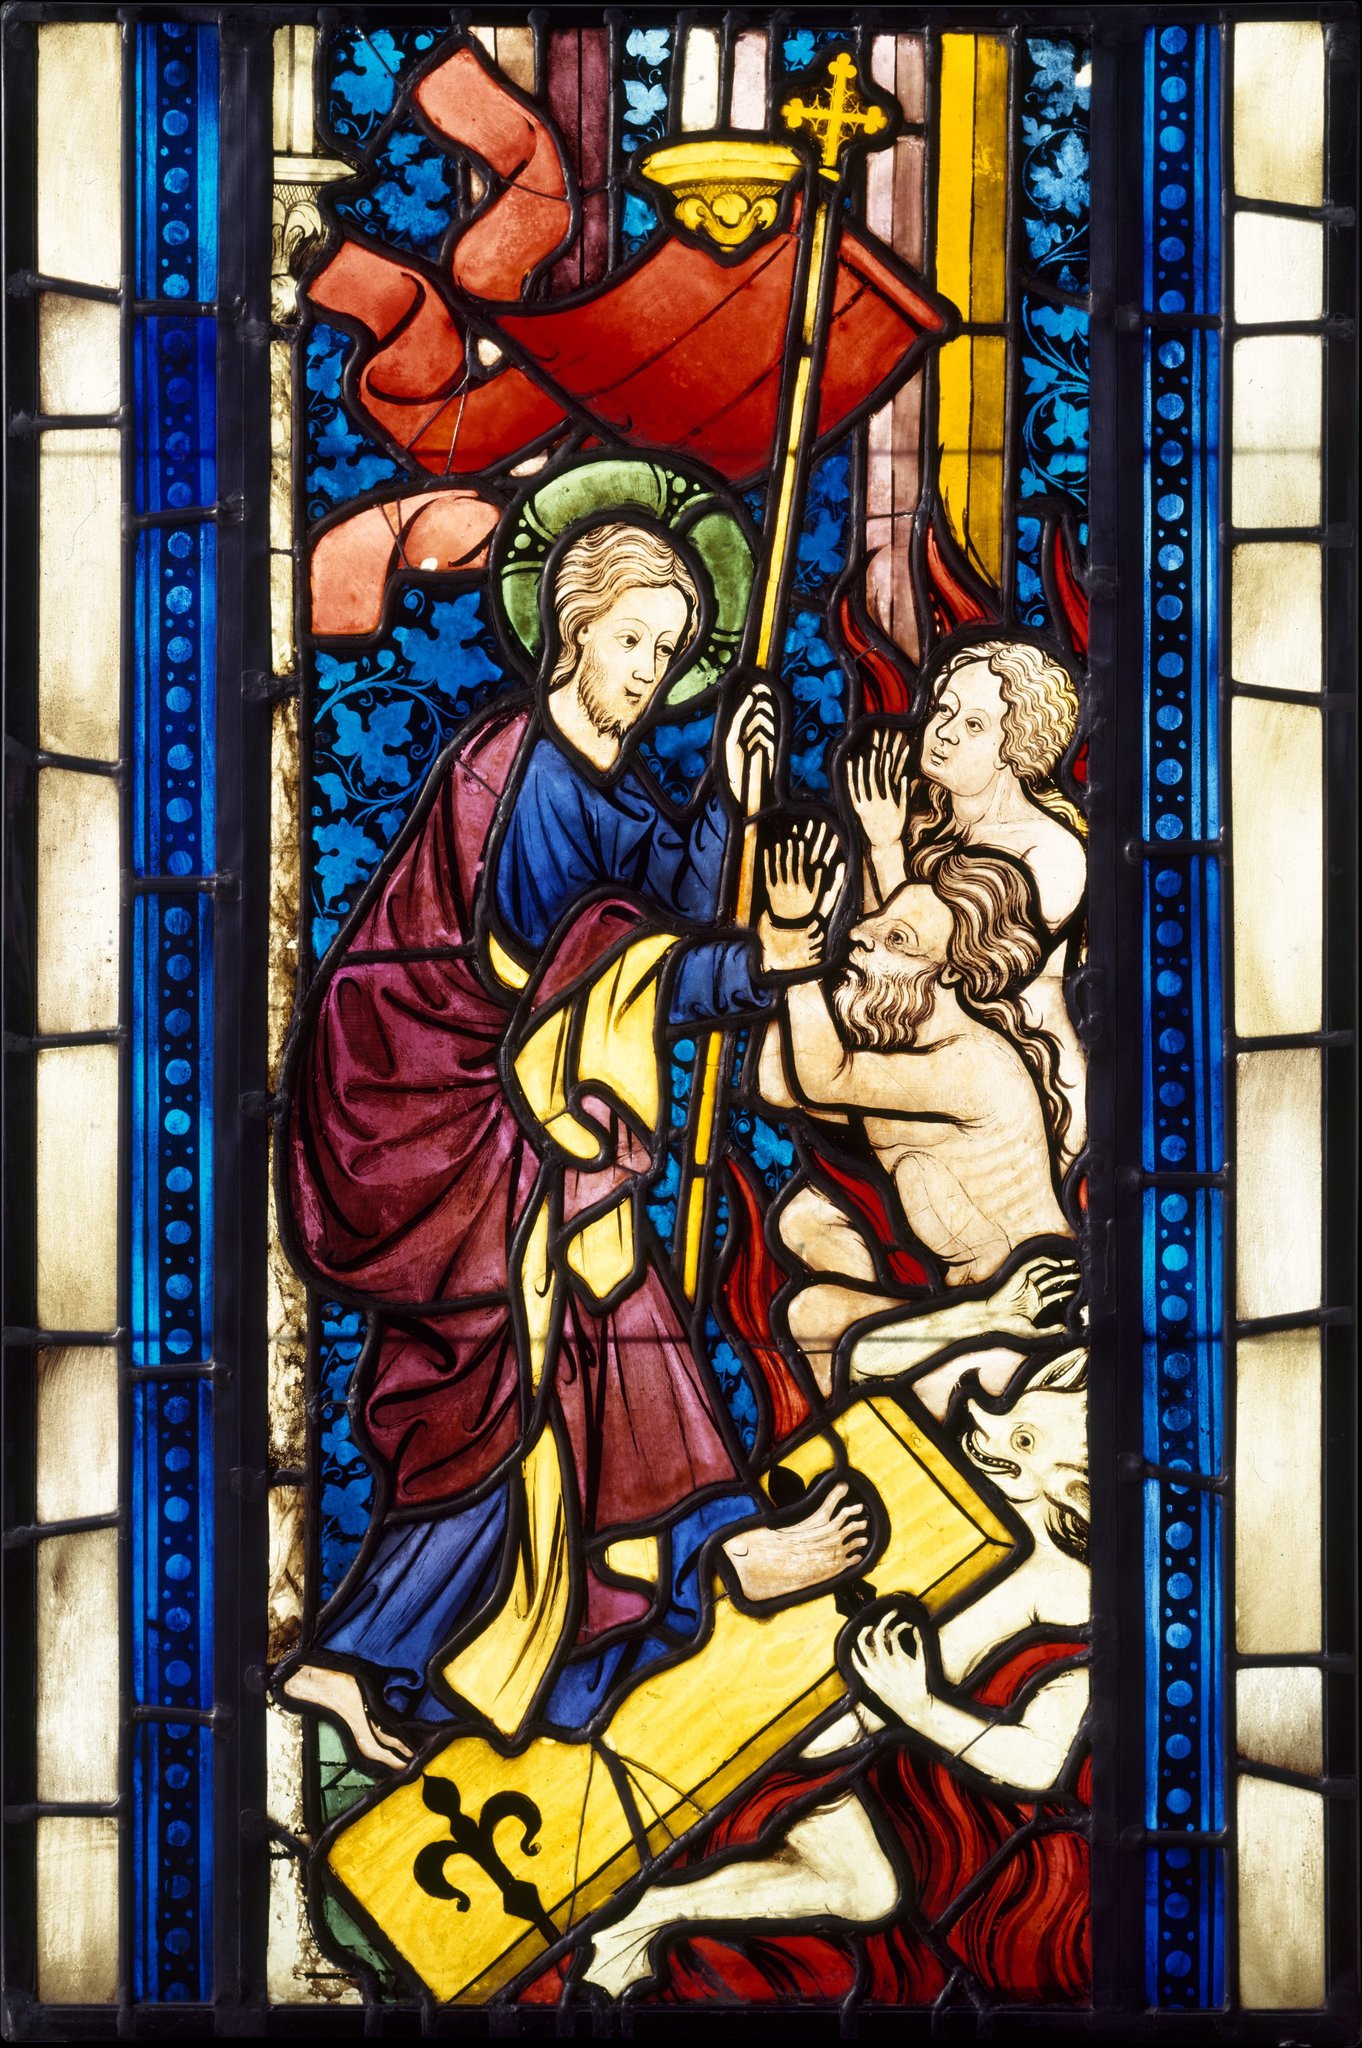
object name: panel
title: The Harrowing of Hell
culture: austrian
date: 1390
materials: glass, metal, paint, pigment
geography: austria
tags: christ,demons,adam,eve